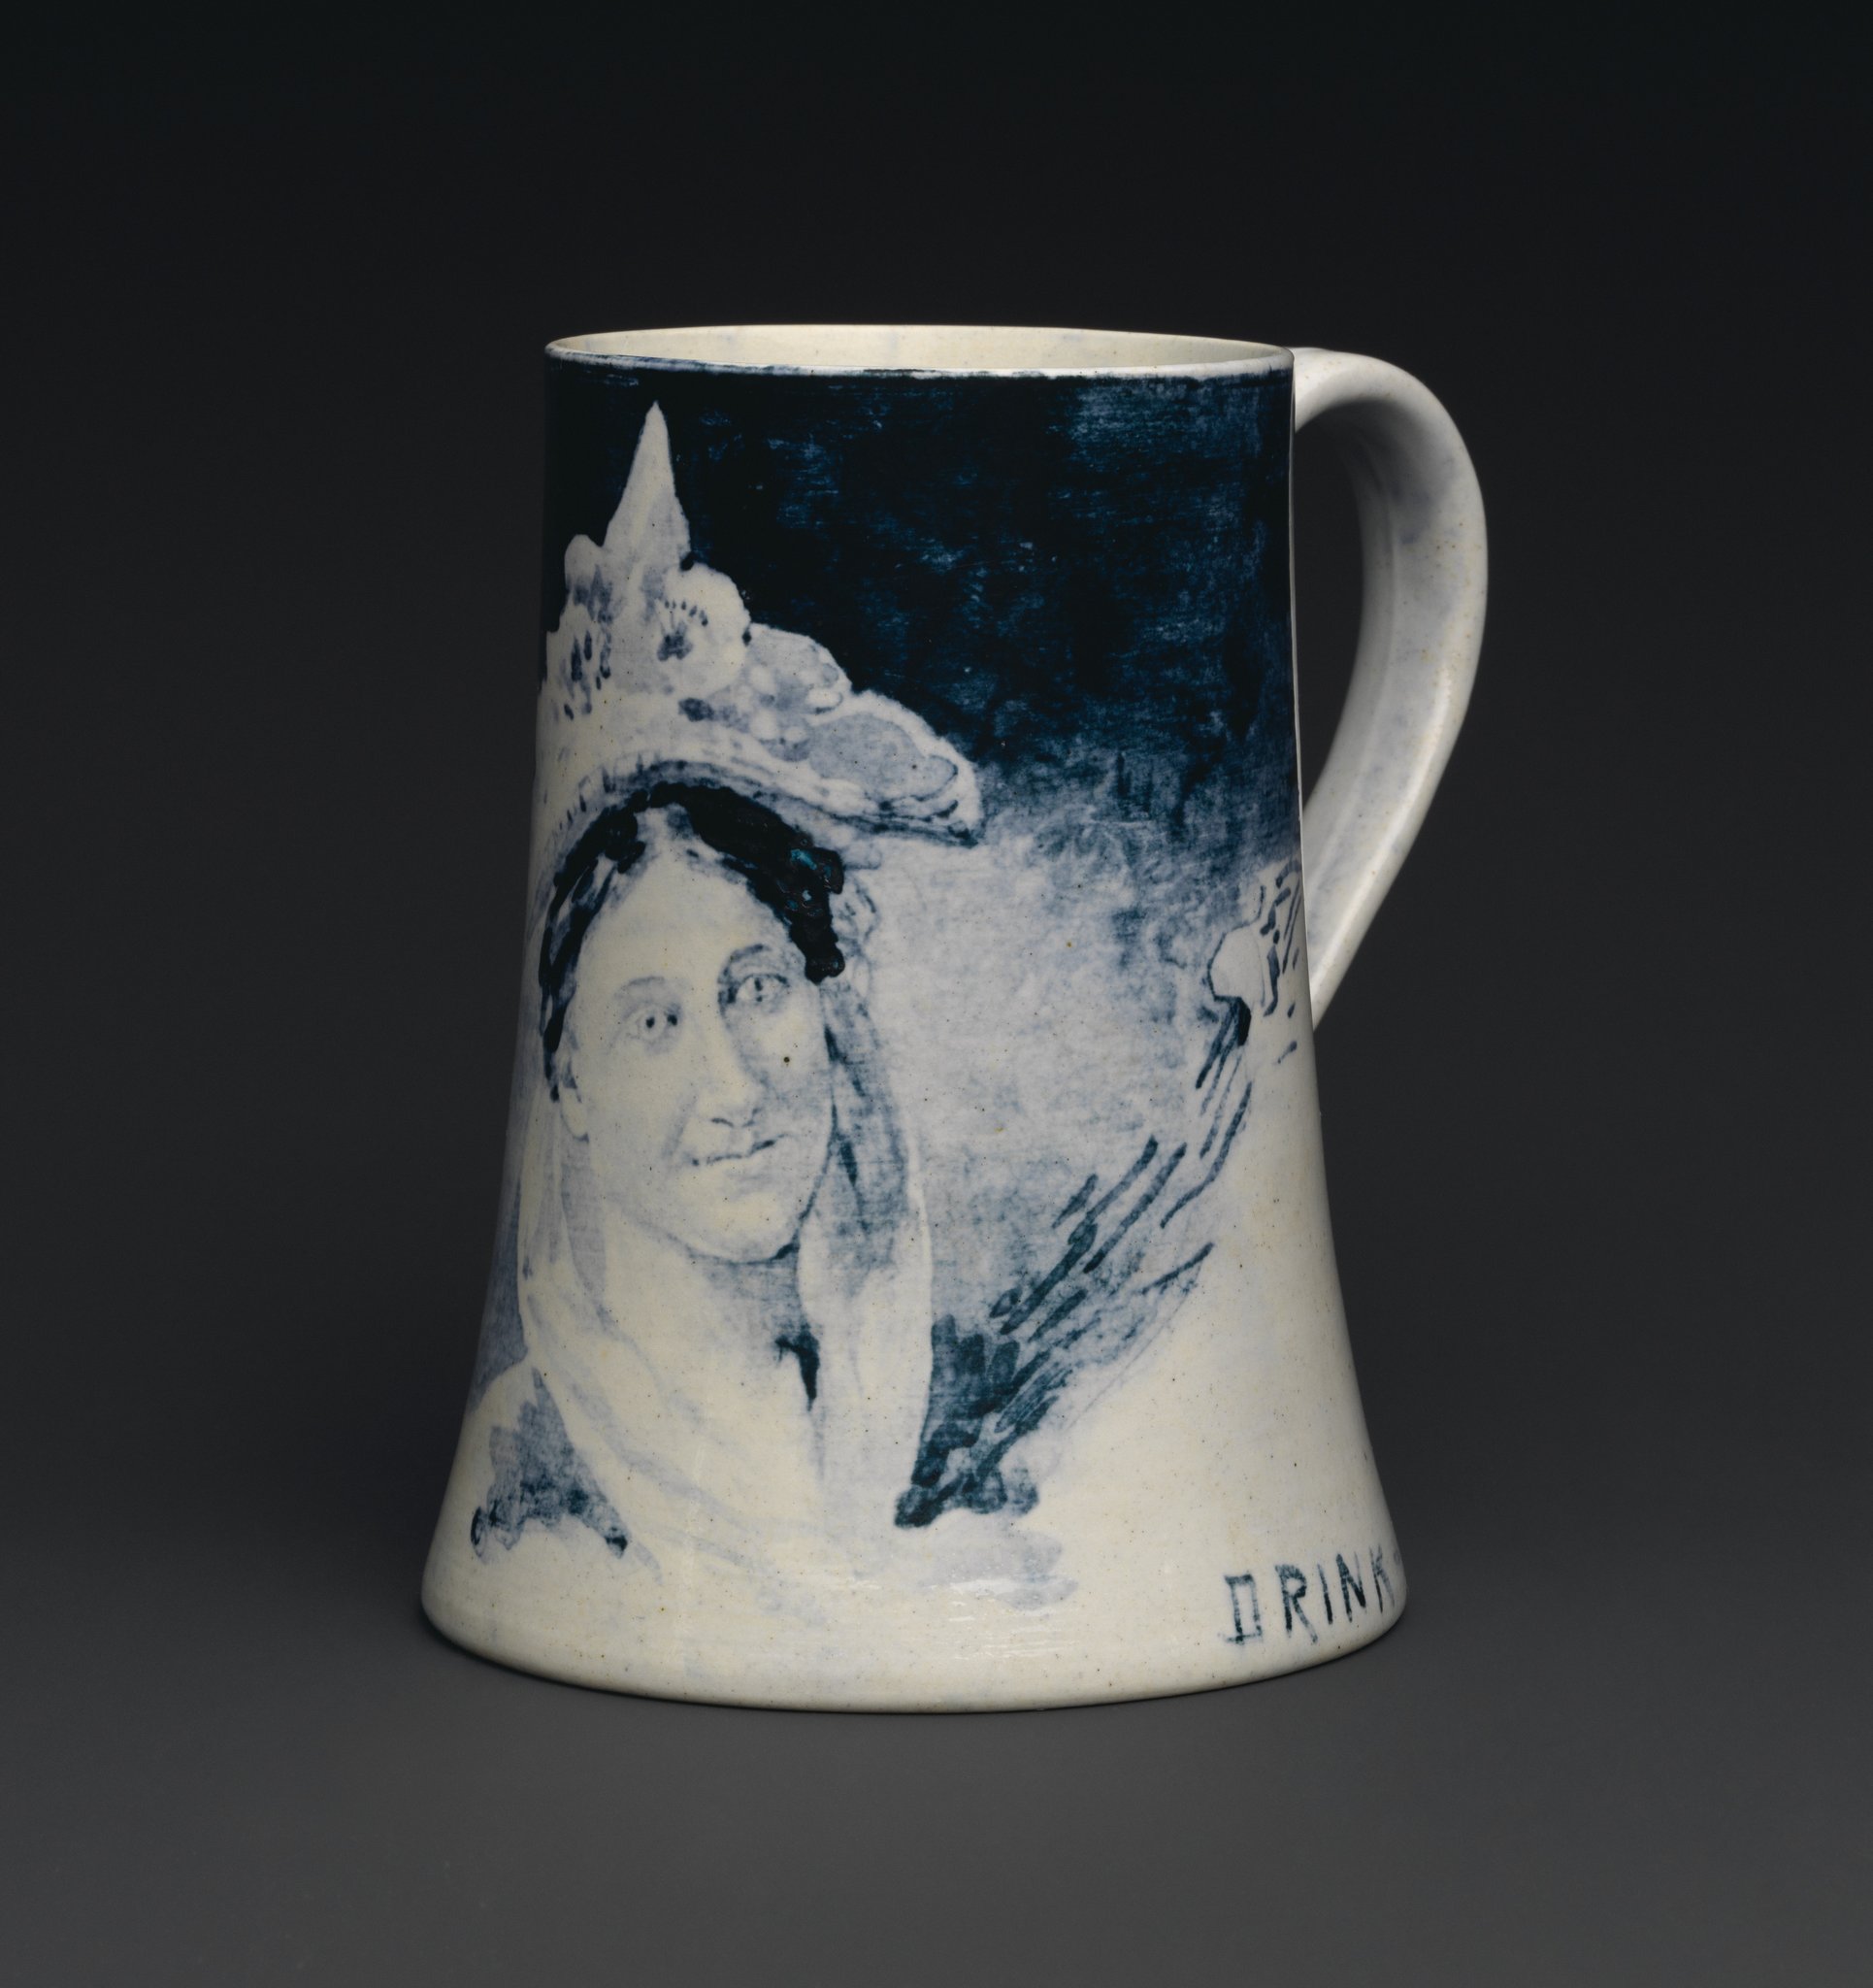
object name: mug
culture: american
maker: volkmar ceramic company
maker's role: maker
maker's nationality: american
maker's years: 1890-1902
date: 1899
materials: earthenware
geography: united states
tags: portraits,women